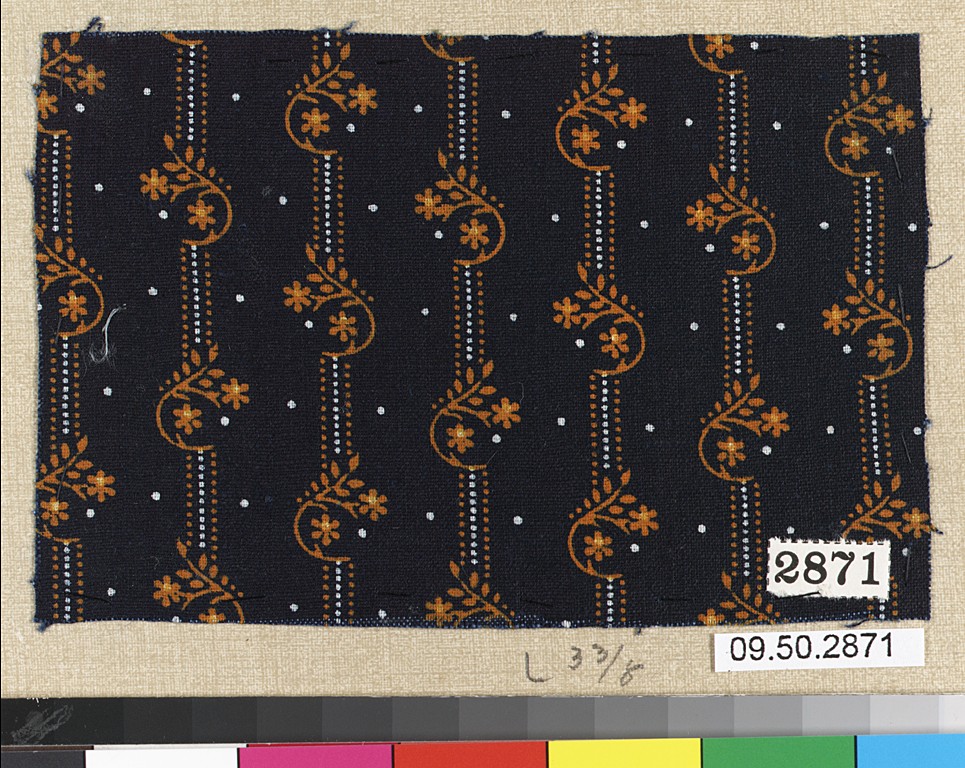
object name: piece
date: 1801-1900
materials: cotton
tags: flowers,leaves